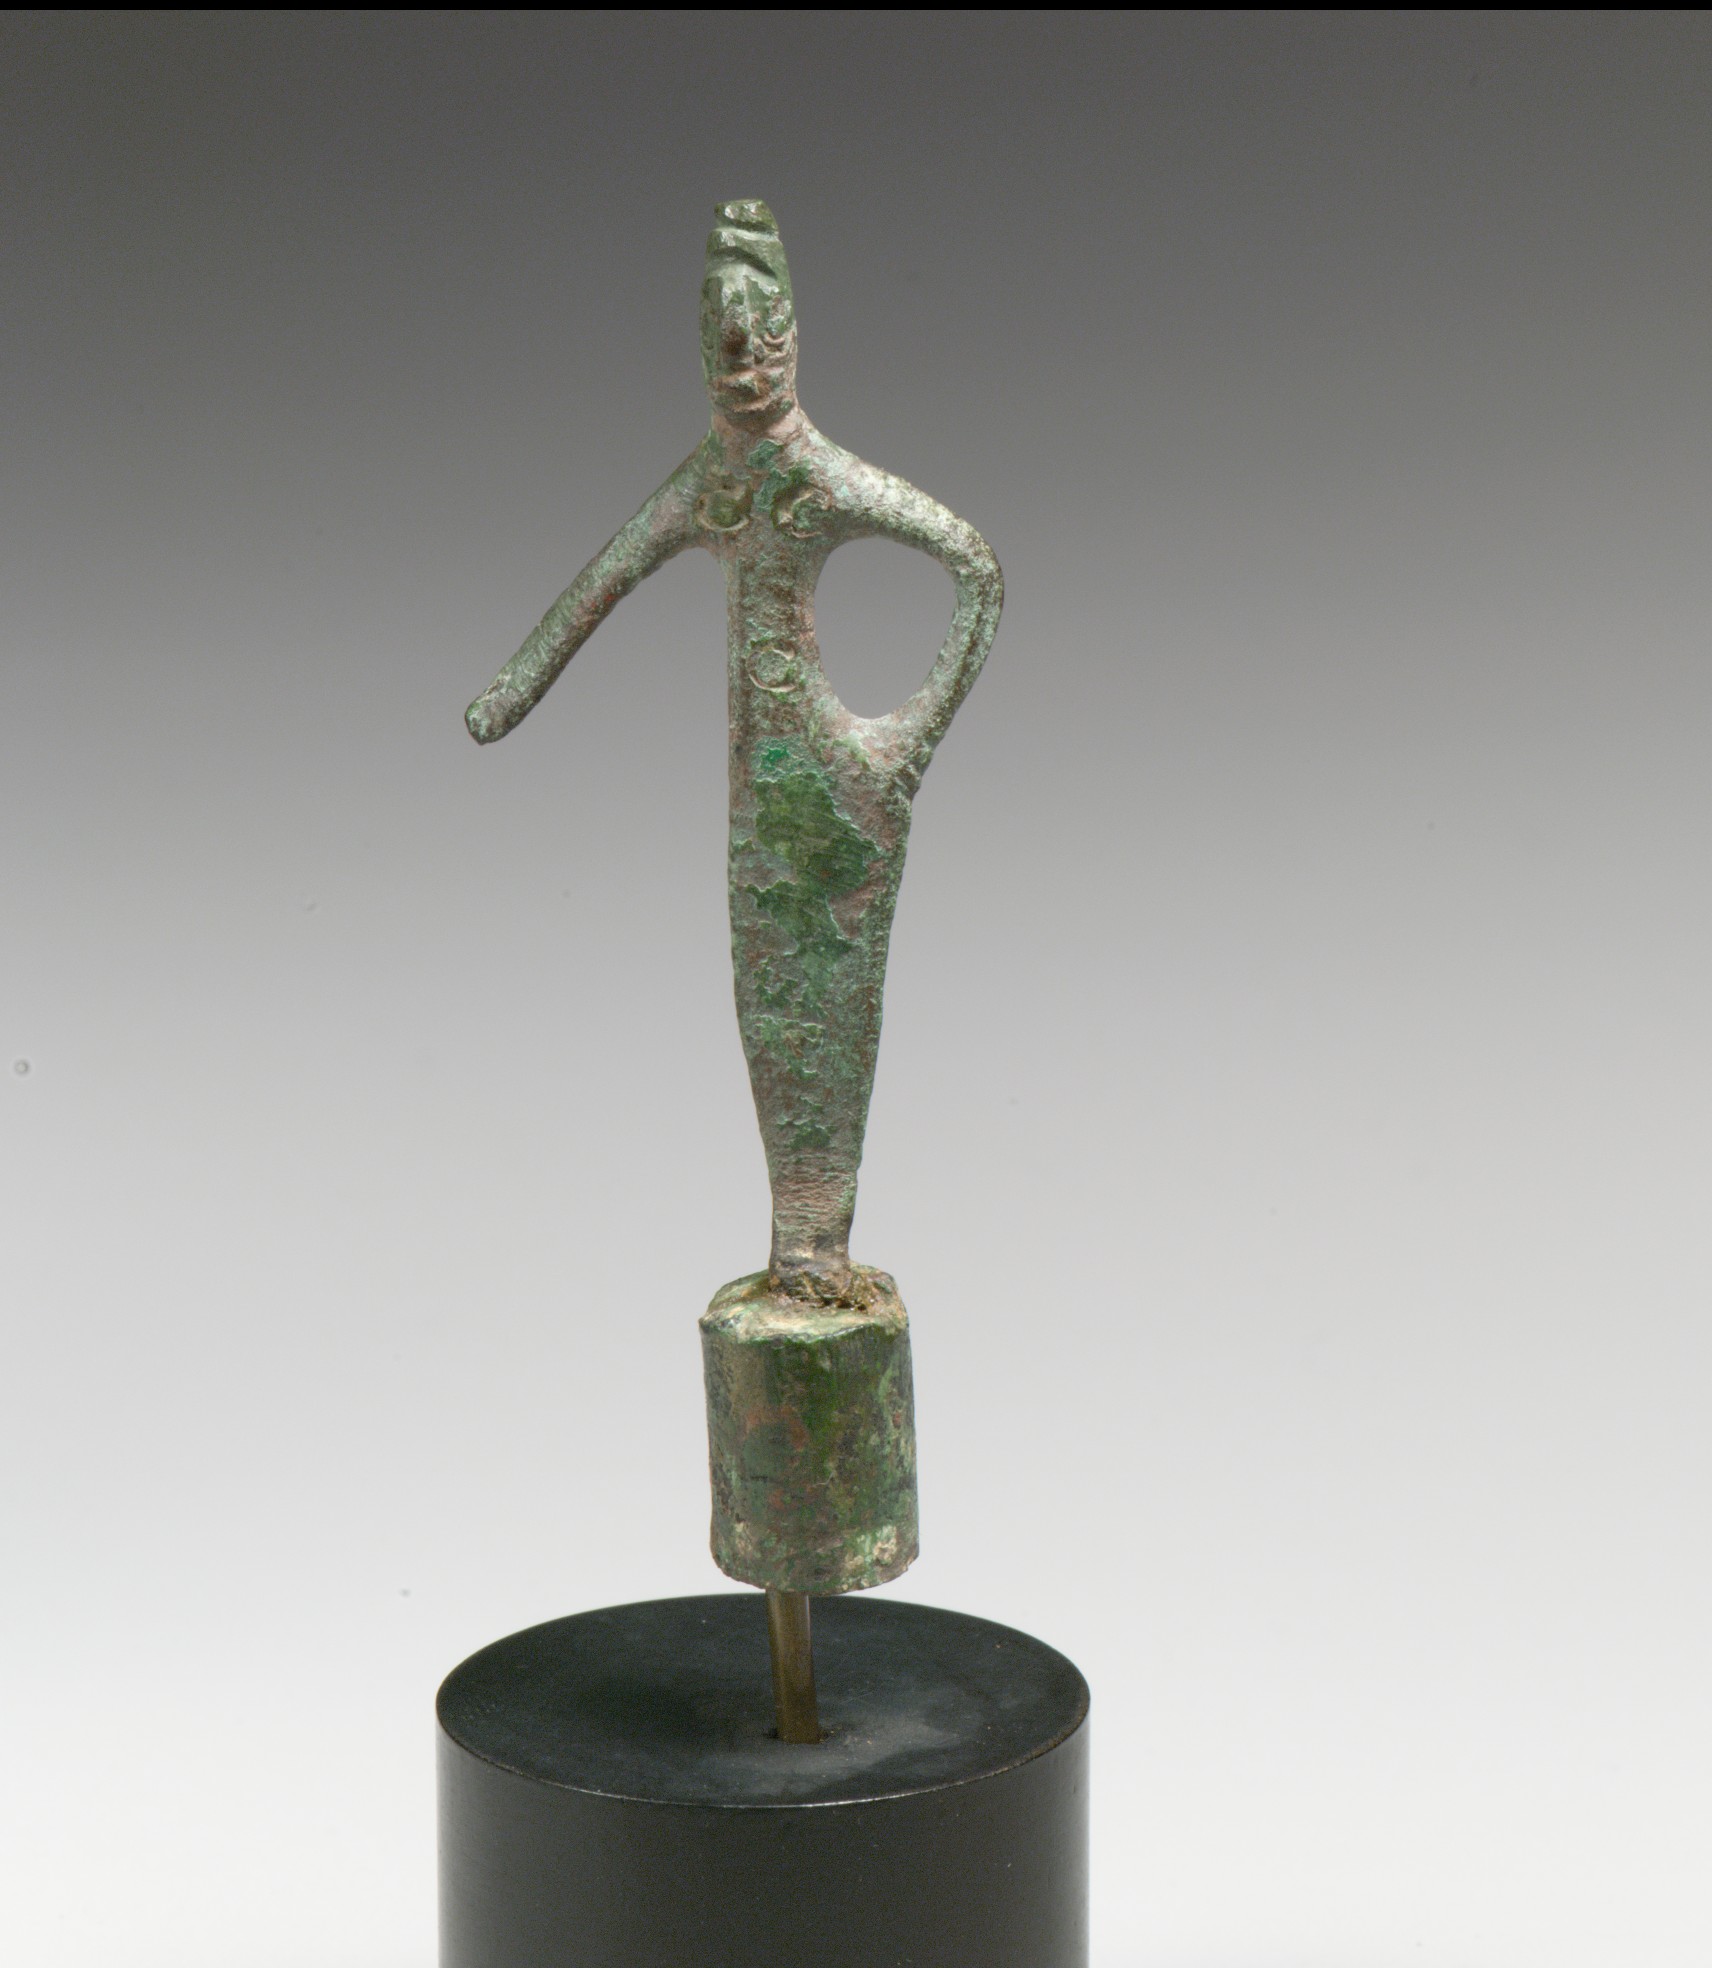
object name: statuette of a woman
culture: etruscan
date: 600-501 BCE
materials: bronze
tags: women